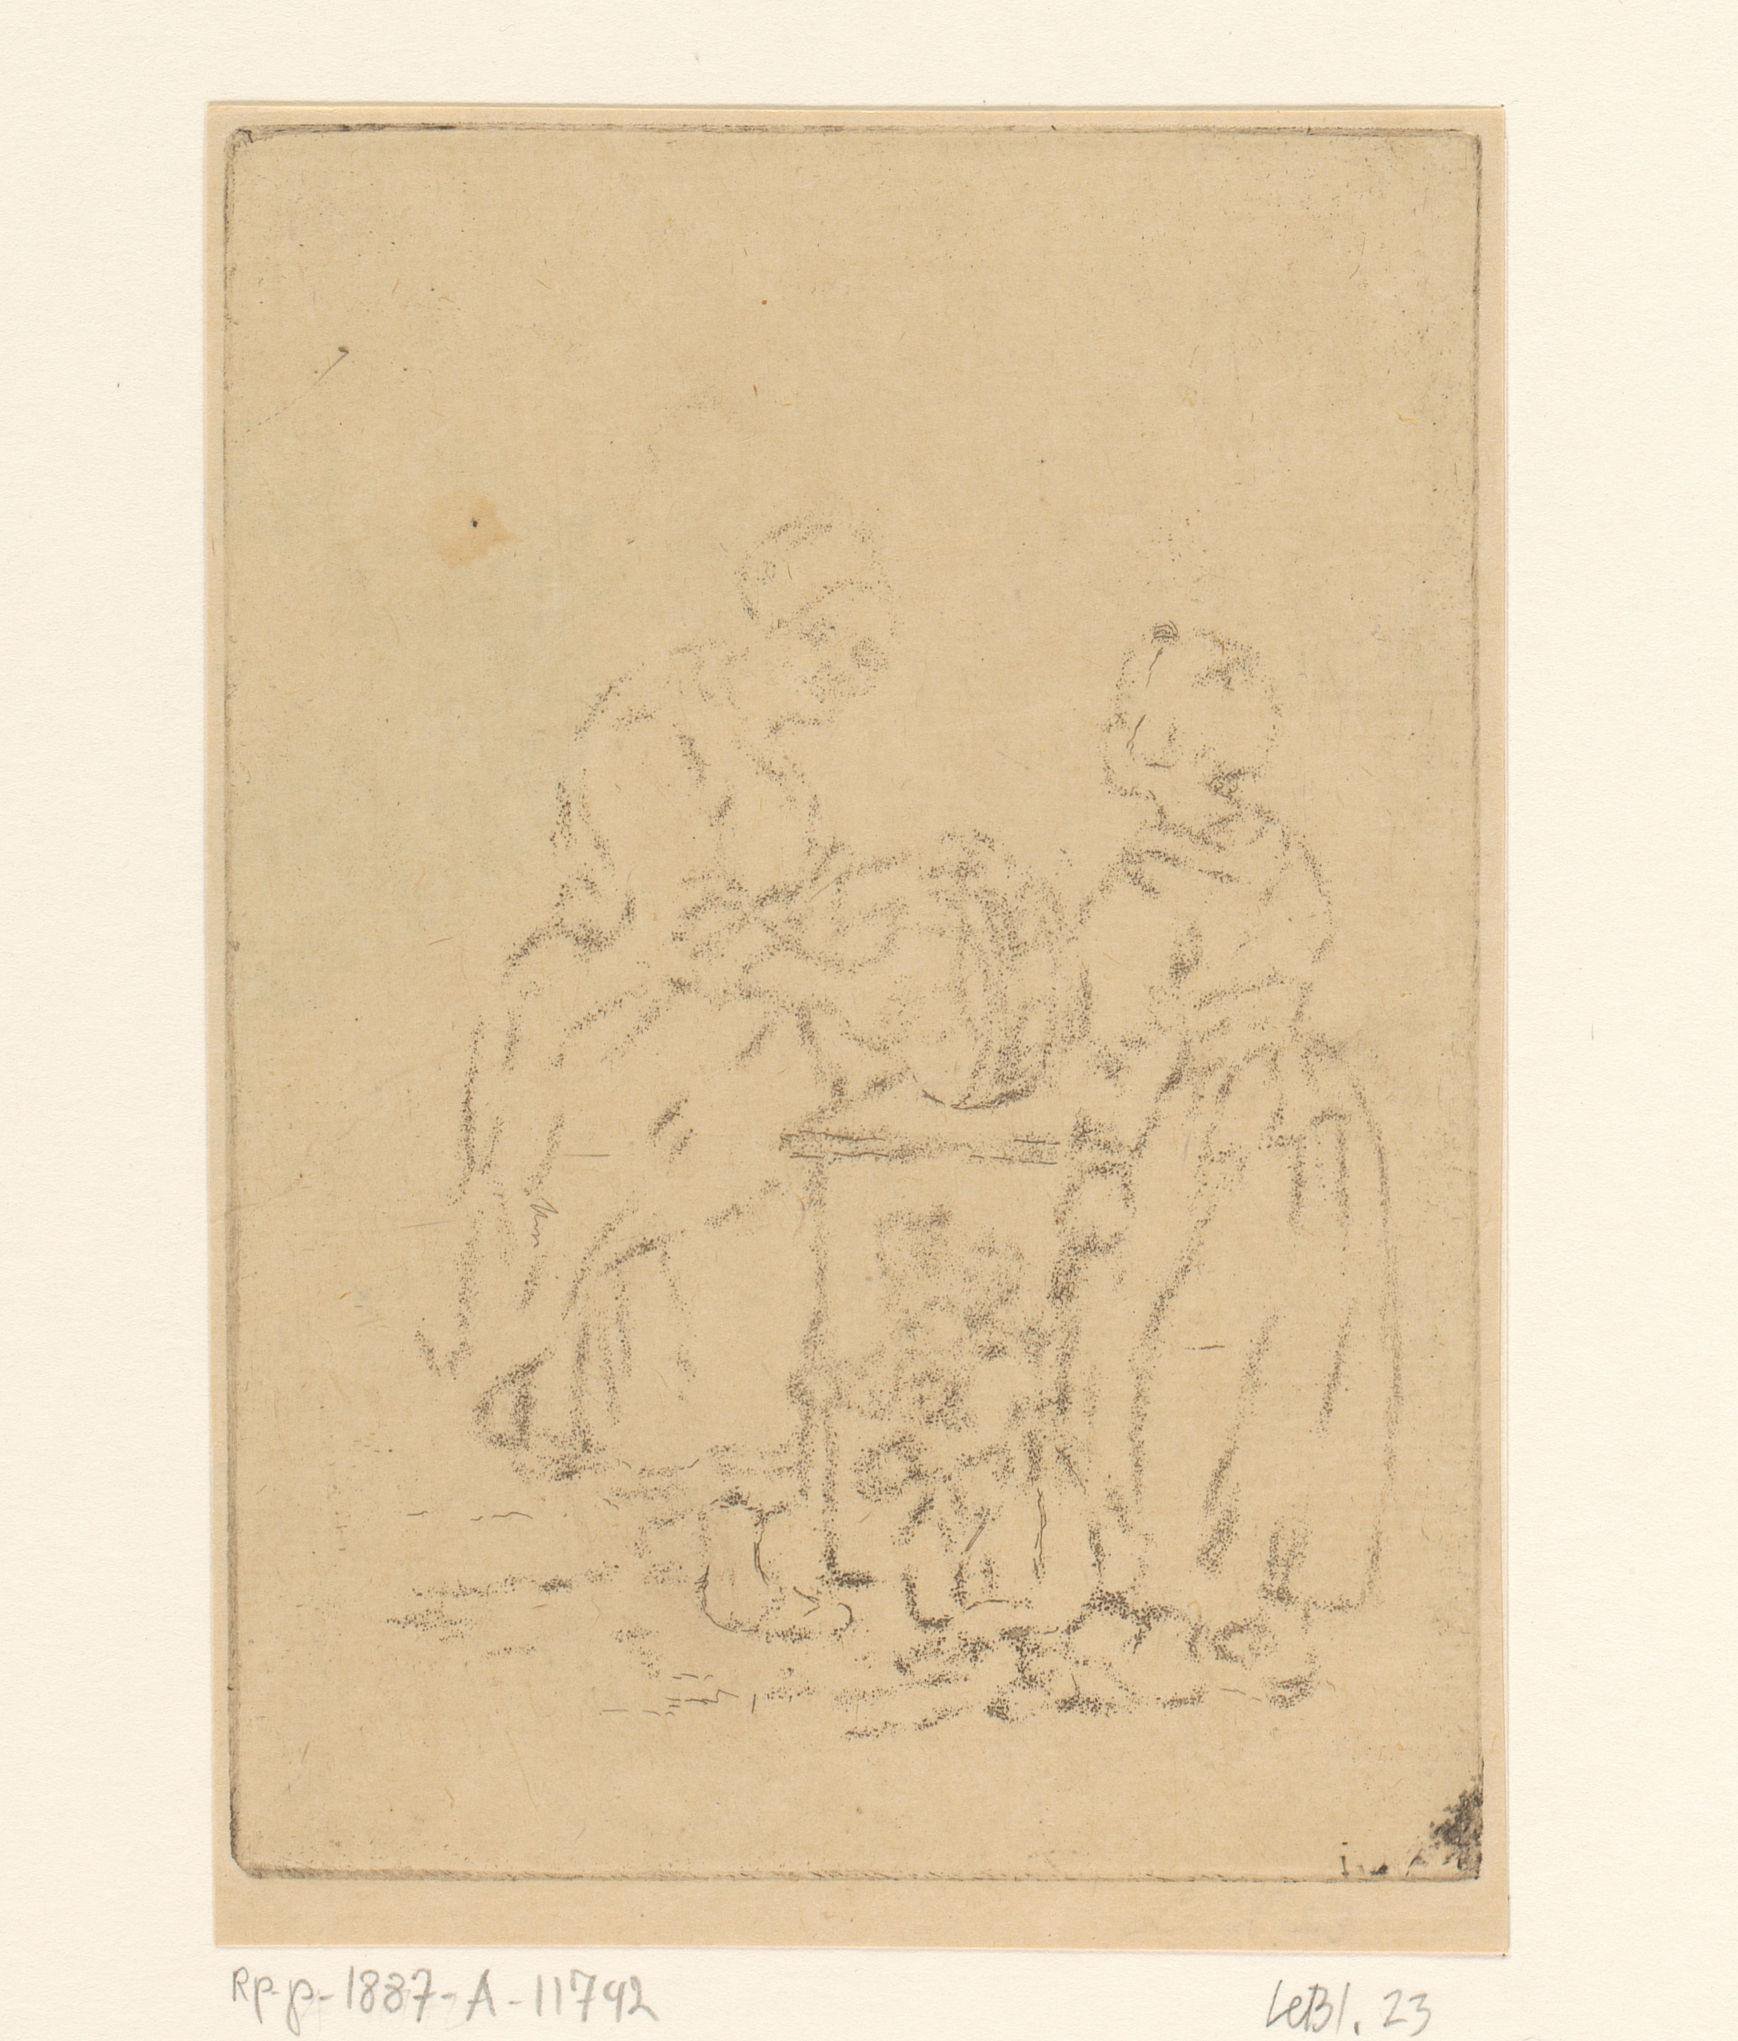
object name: print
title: Twee vrouwen in gesprek tijdens de afwas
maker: christina chalon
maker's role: draughtsman, print maker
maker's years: 1748-1808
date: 1758-1808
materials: paper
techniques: aquatint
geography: leiden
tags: implements for learning to walk, go-cart, mother and child(ren), woman and child(ren) (family group) (with number of children), washing up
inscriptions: collector's mark: Lugt 2228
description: Een oude vrouw staat aan het aanrecht en schuurt een ketel uit. Een jongere vrouw praat met haar. Ze houdt een kindje vast met een leiband en een tuigje.